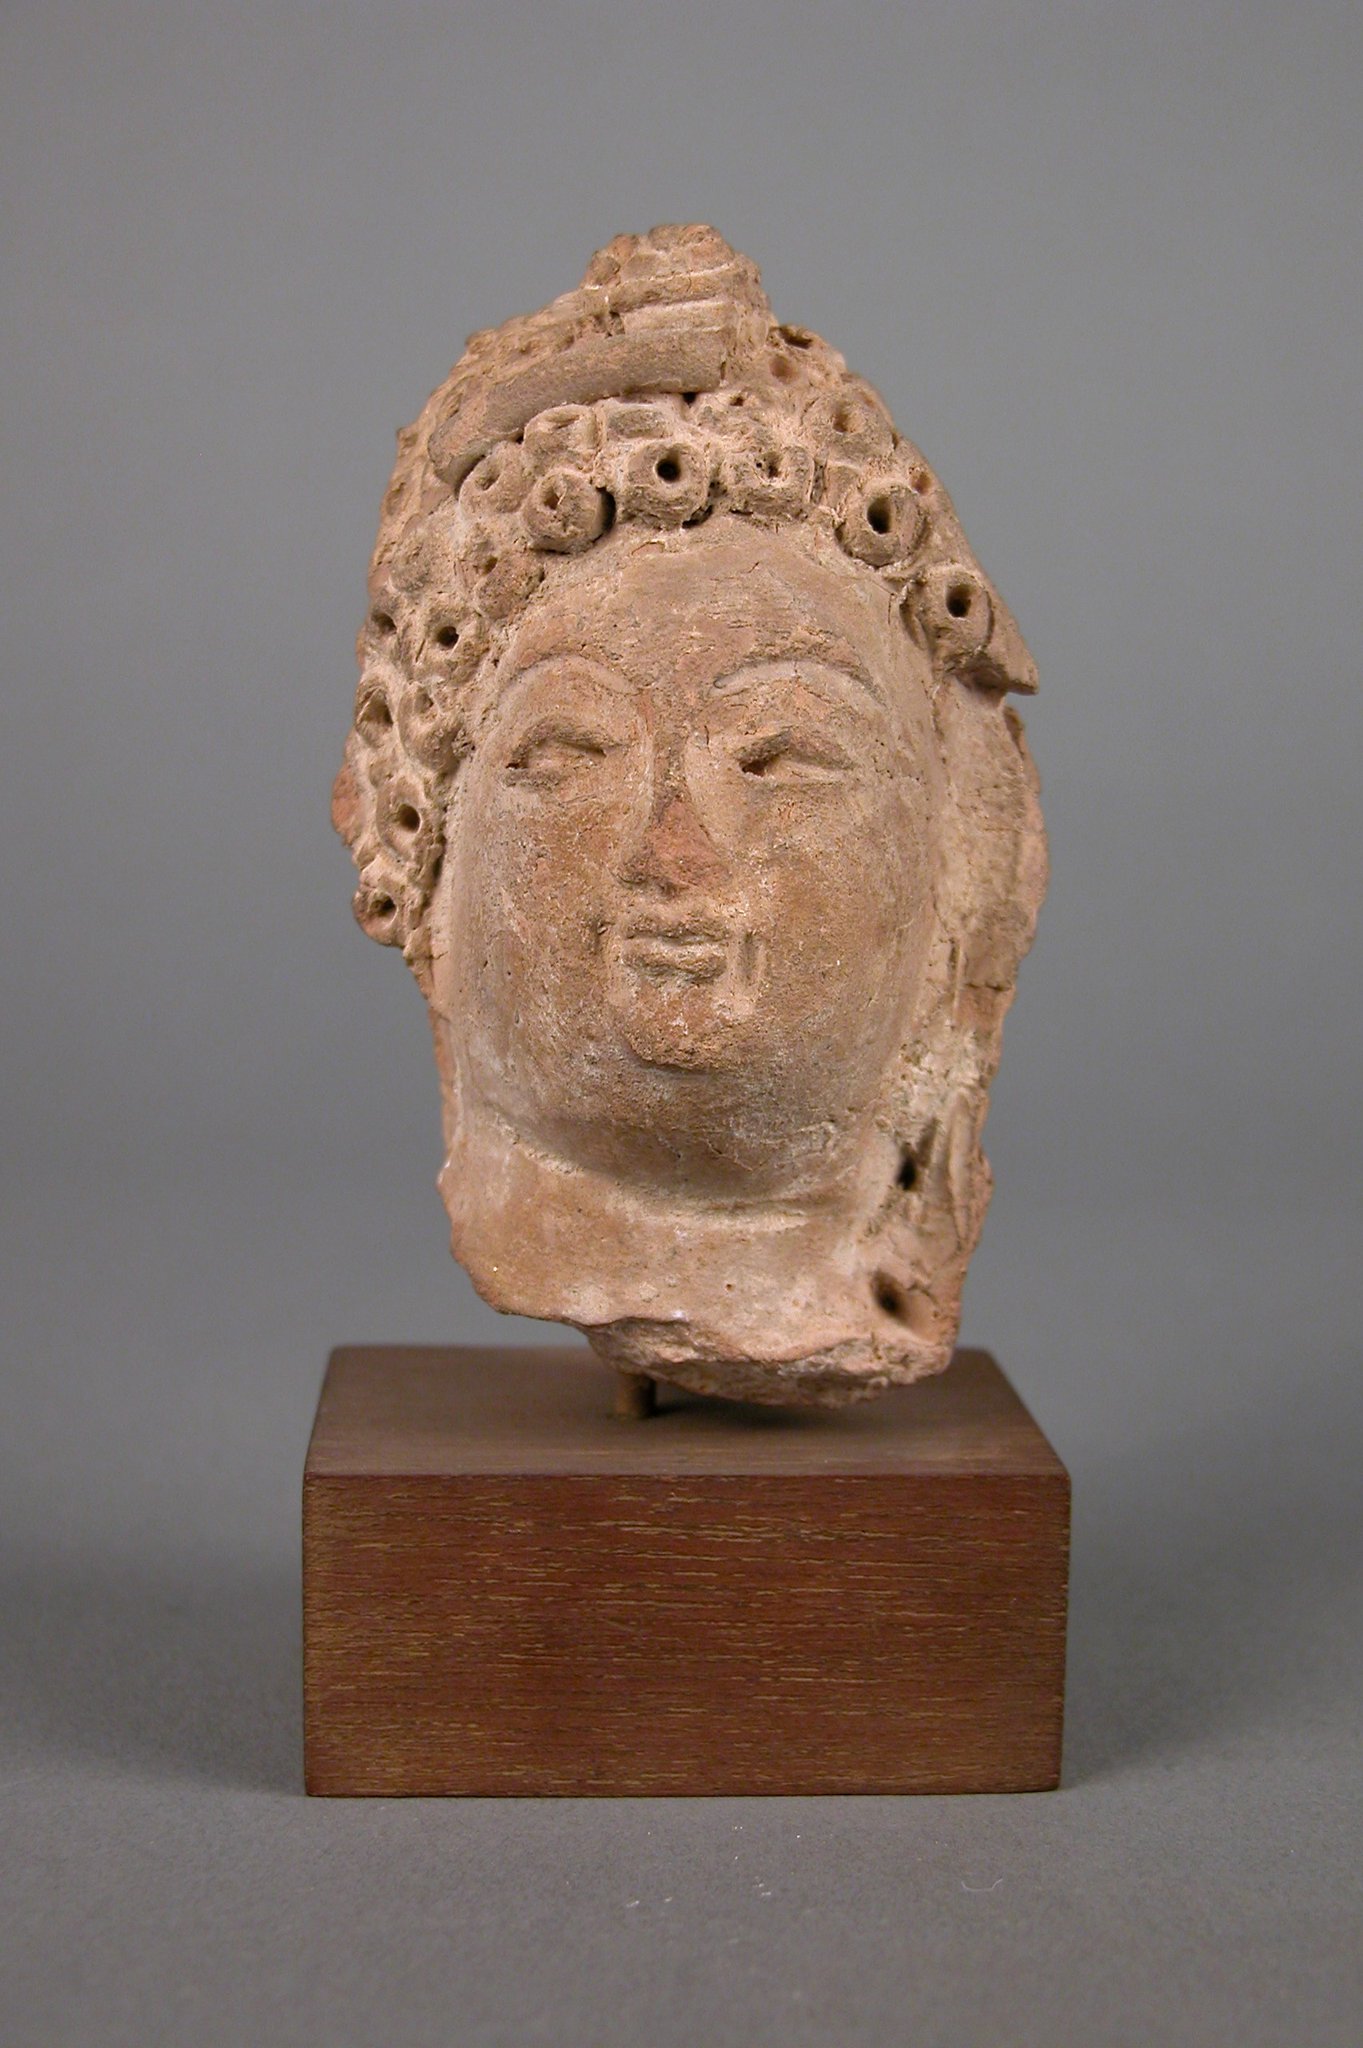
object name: head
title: Head of a Bodhisattva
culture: central asian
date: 1101-1133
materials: clay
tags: heads,buddhism,bodhisattvas